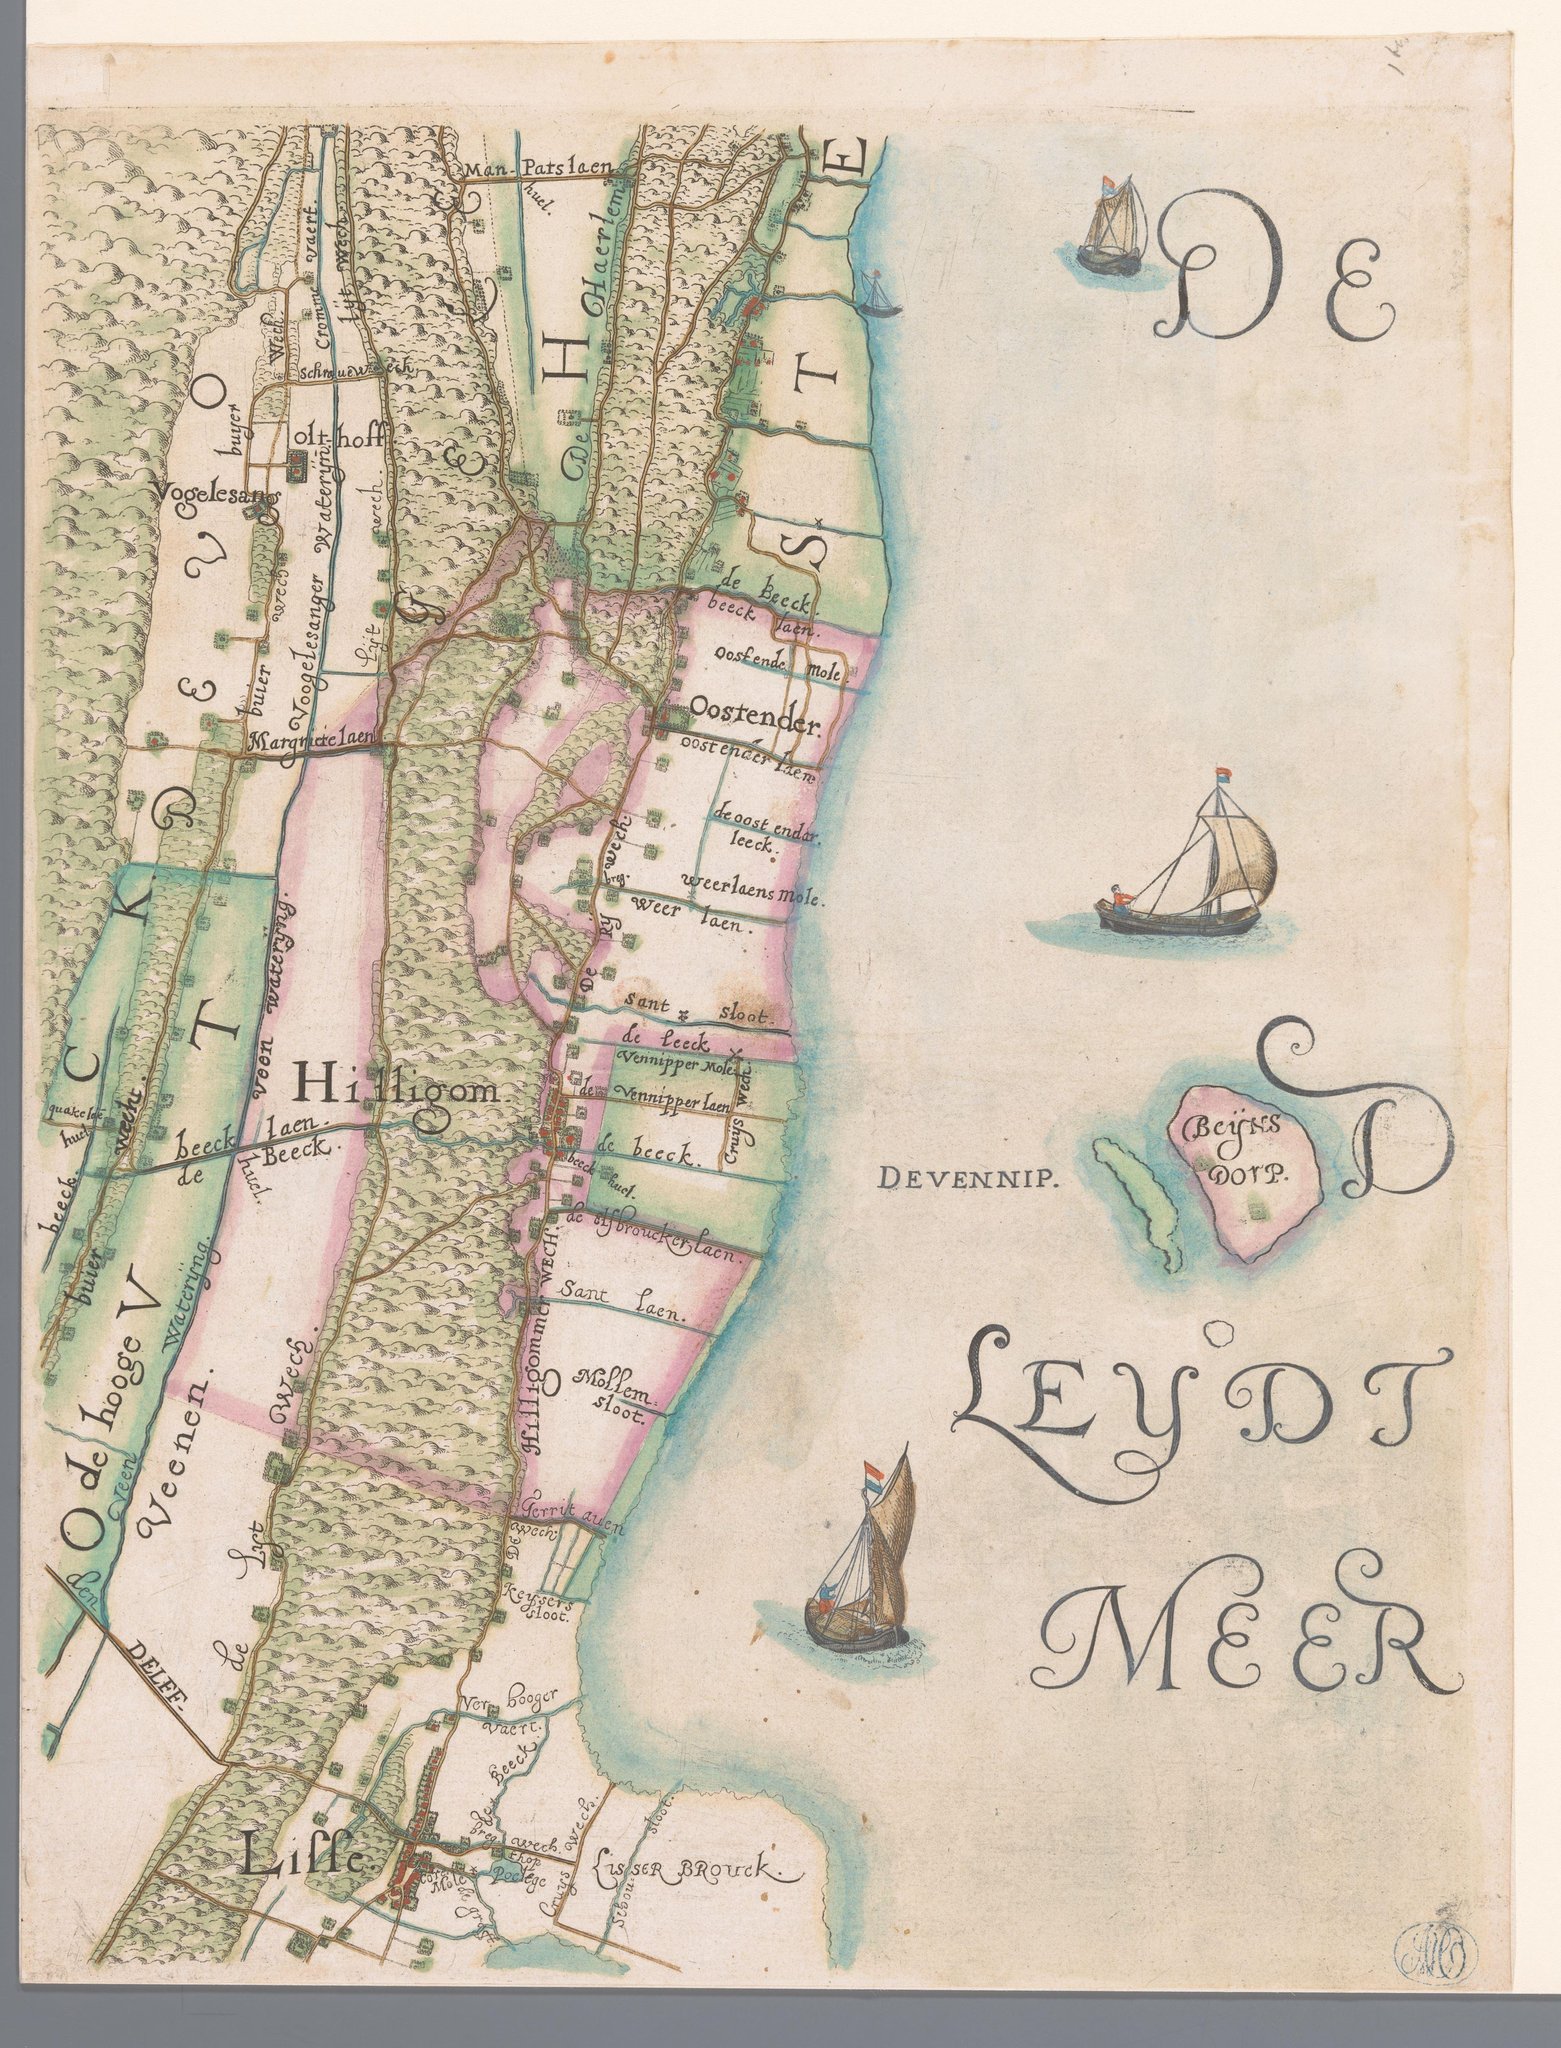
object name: map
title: Deel van een kaart van het Hoogheemraadschap van Rijnland, met Hillegom en Lisse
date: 1615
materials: paper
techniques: engraving, etching, hand coloring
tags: maps of separate countries or regions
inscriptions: collector's mark: Lugt 195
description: Deel van een kaart van Rijnland, bestaande uit 27 delen.